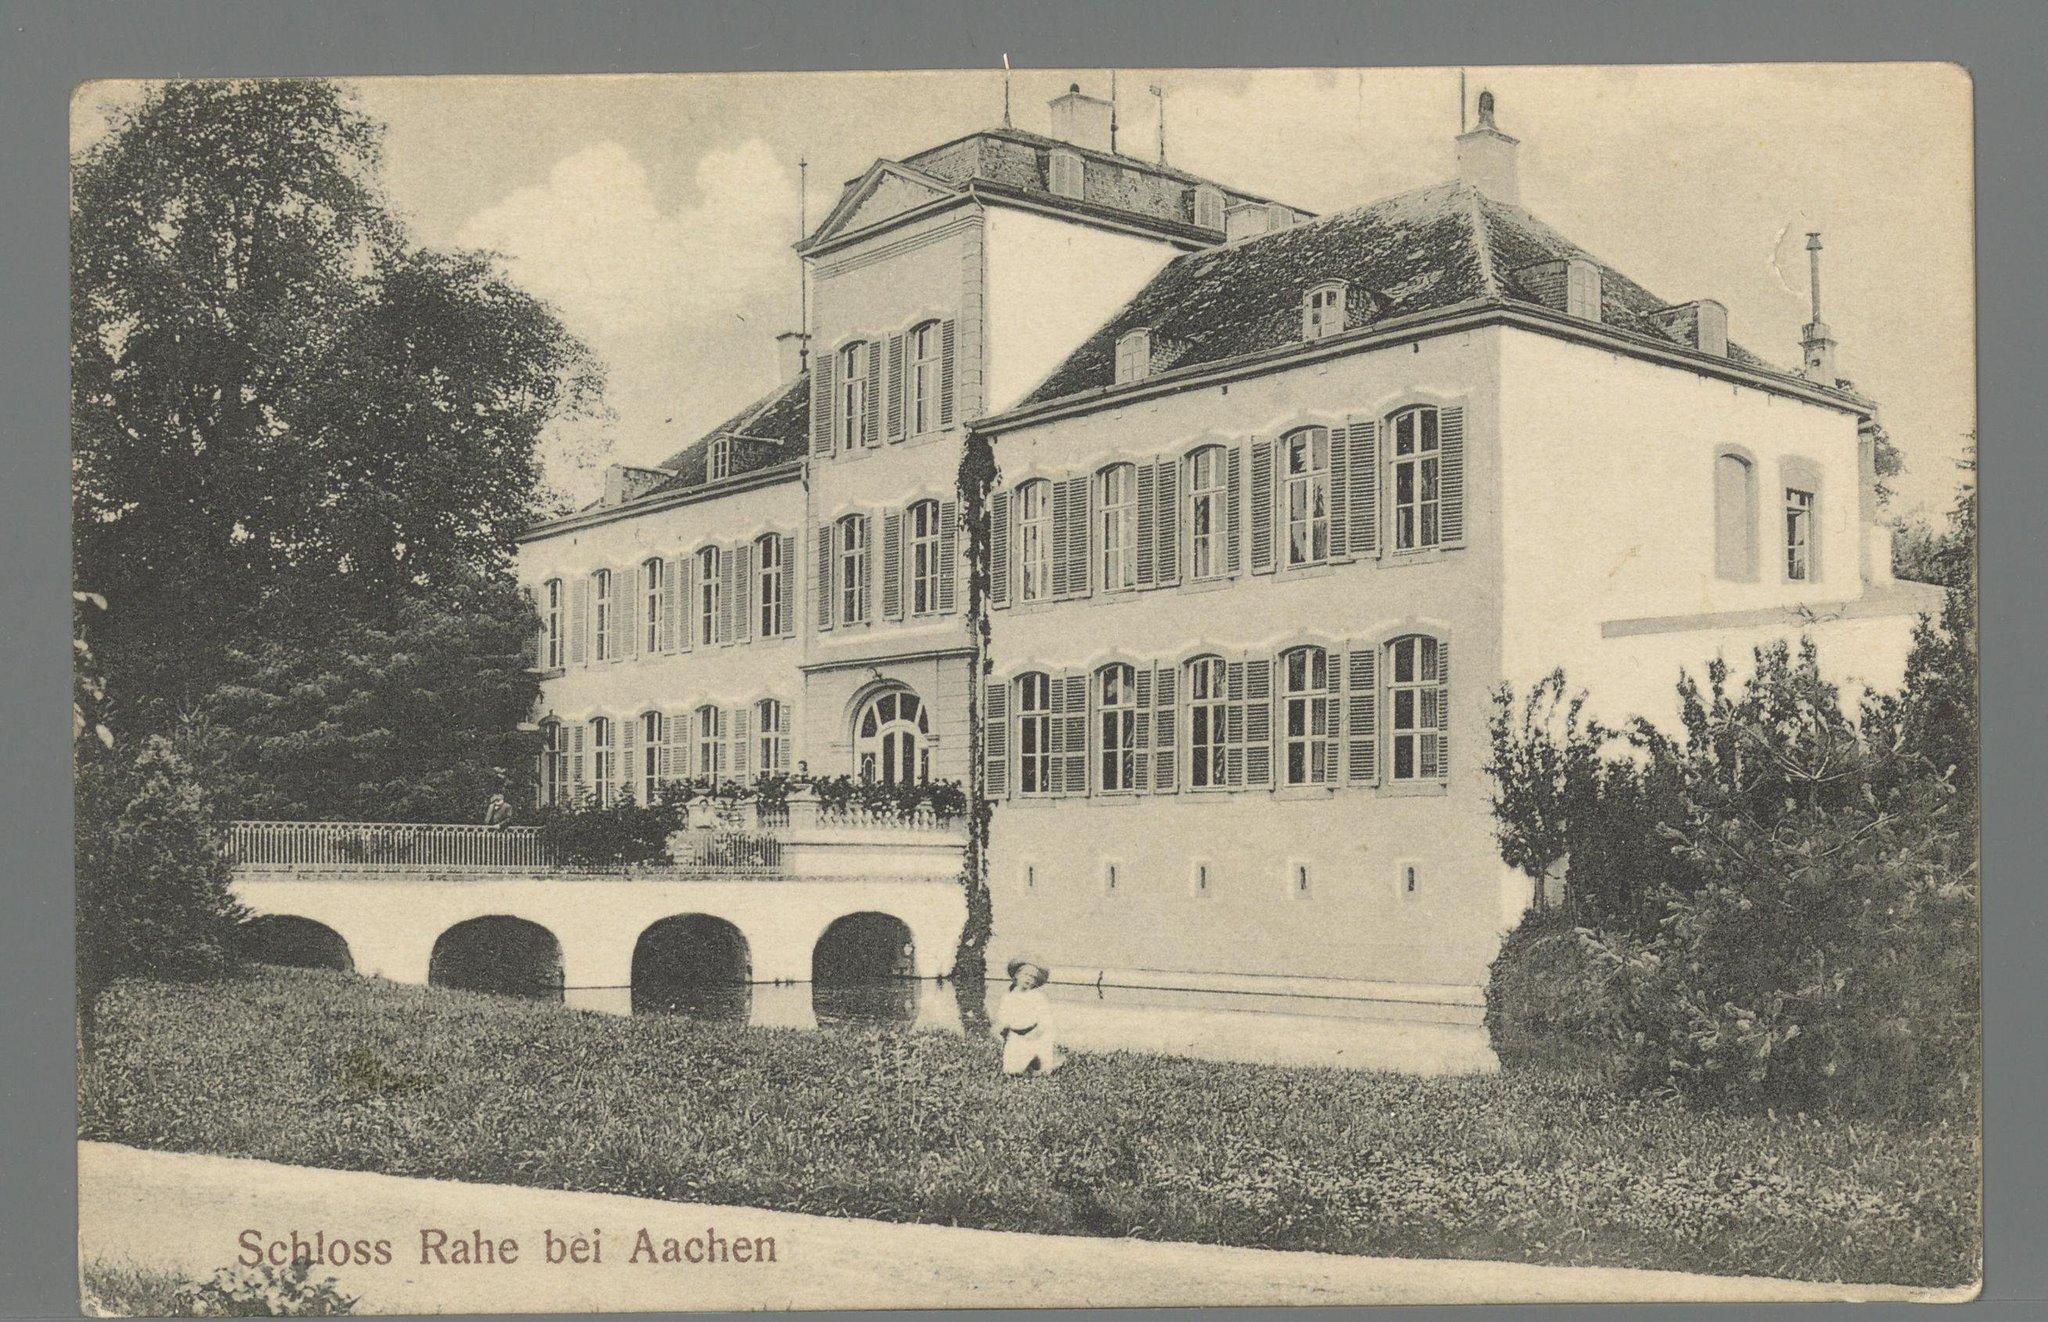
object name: ansichtkaart, prentbriefkaart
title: Schloss Rahe bei Aachen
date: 1905-1930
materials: cardboard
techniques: photograph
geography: aachen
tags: castle, canal